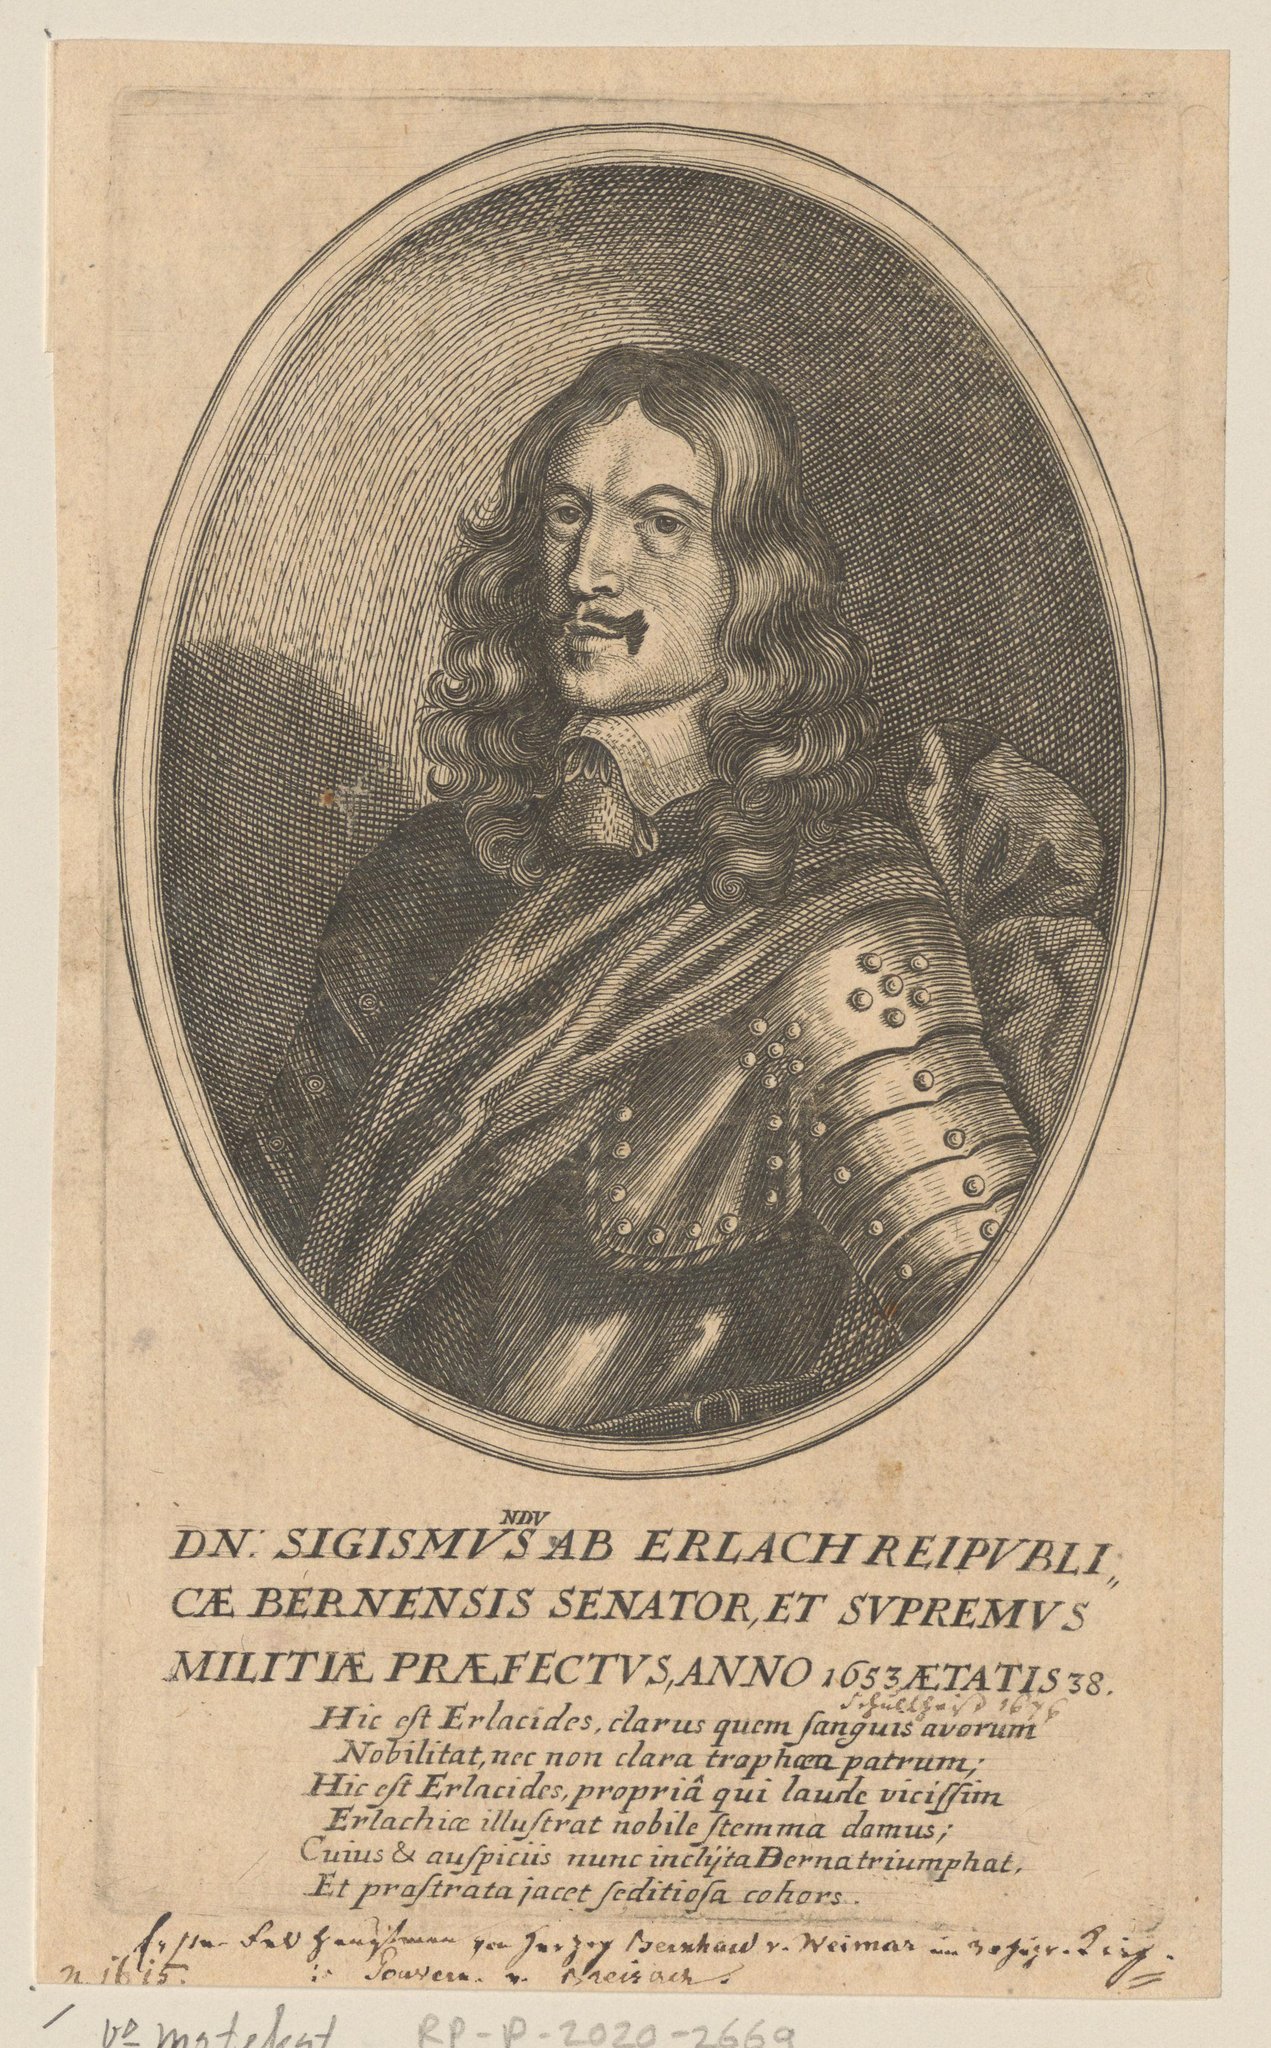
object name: print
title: Portret van Sigmund von Erlach op 38-jarige leeftijd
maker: peter aubry (iii)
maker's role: print maker, publisher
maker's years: 1610-1686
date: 1653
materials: paper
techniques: engraving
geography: straatsburg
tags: politician, historical persons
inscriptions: inscription: ‘[...] Bernhard v. Weimar [...] Gouvern. v. Breisach’, inscription: ‘[...] Susanna [...] 6 mart 1657 [...] v. Doringenberg [...] zu Hertzberg [...]’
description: Met zesregelig Latijns vers onder het portret.